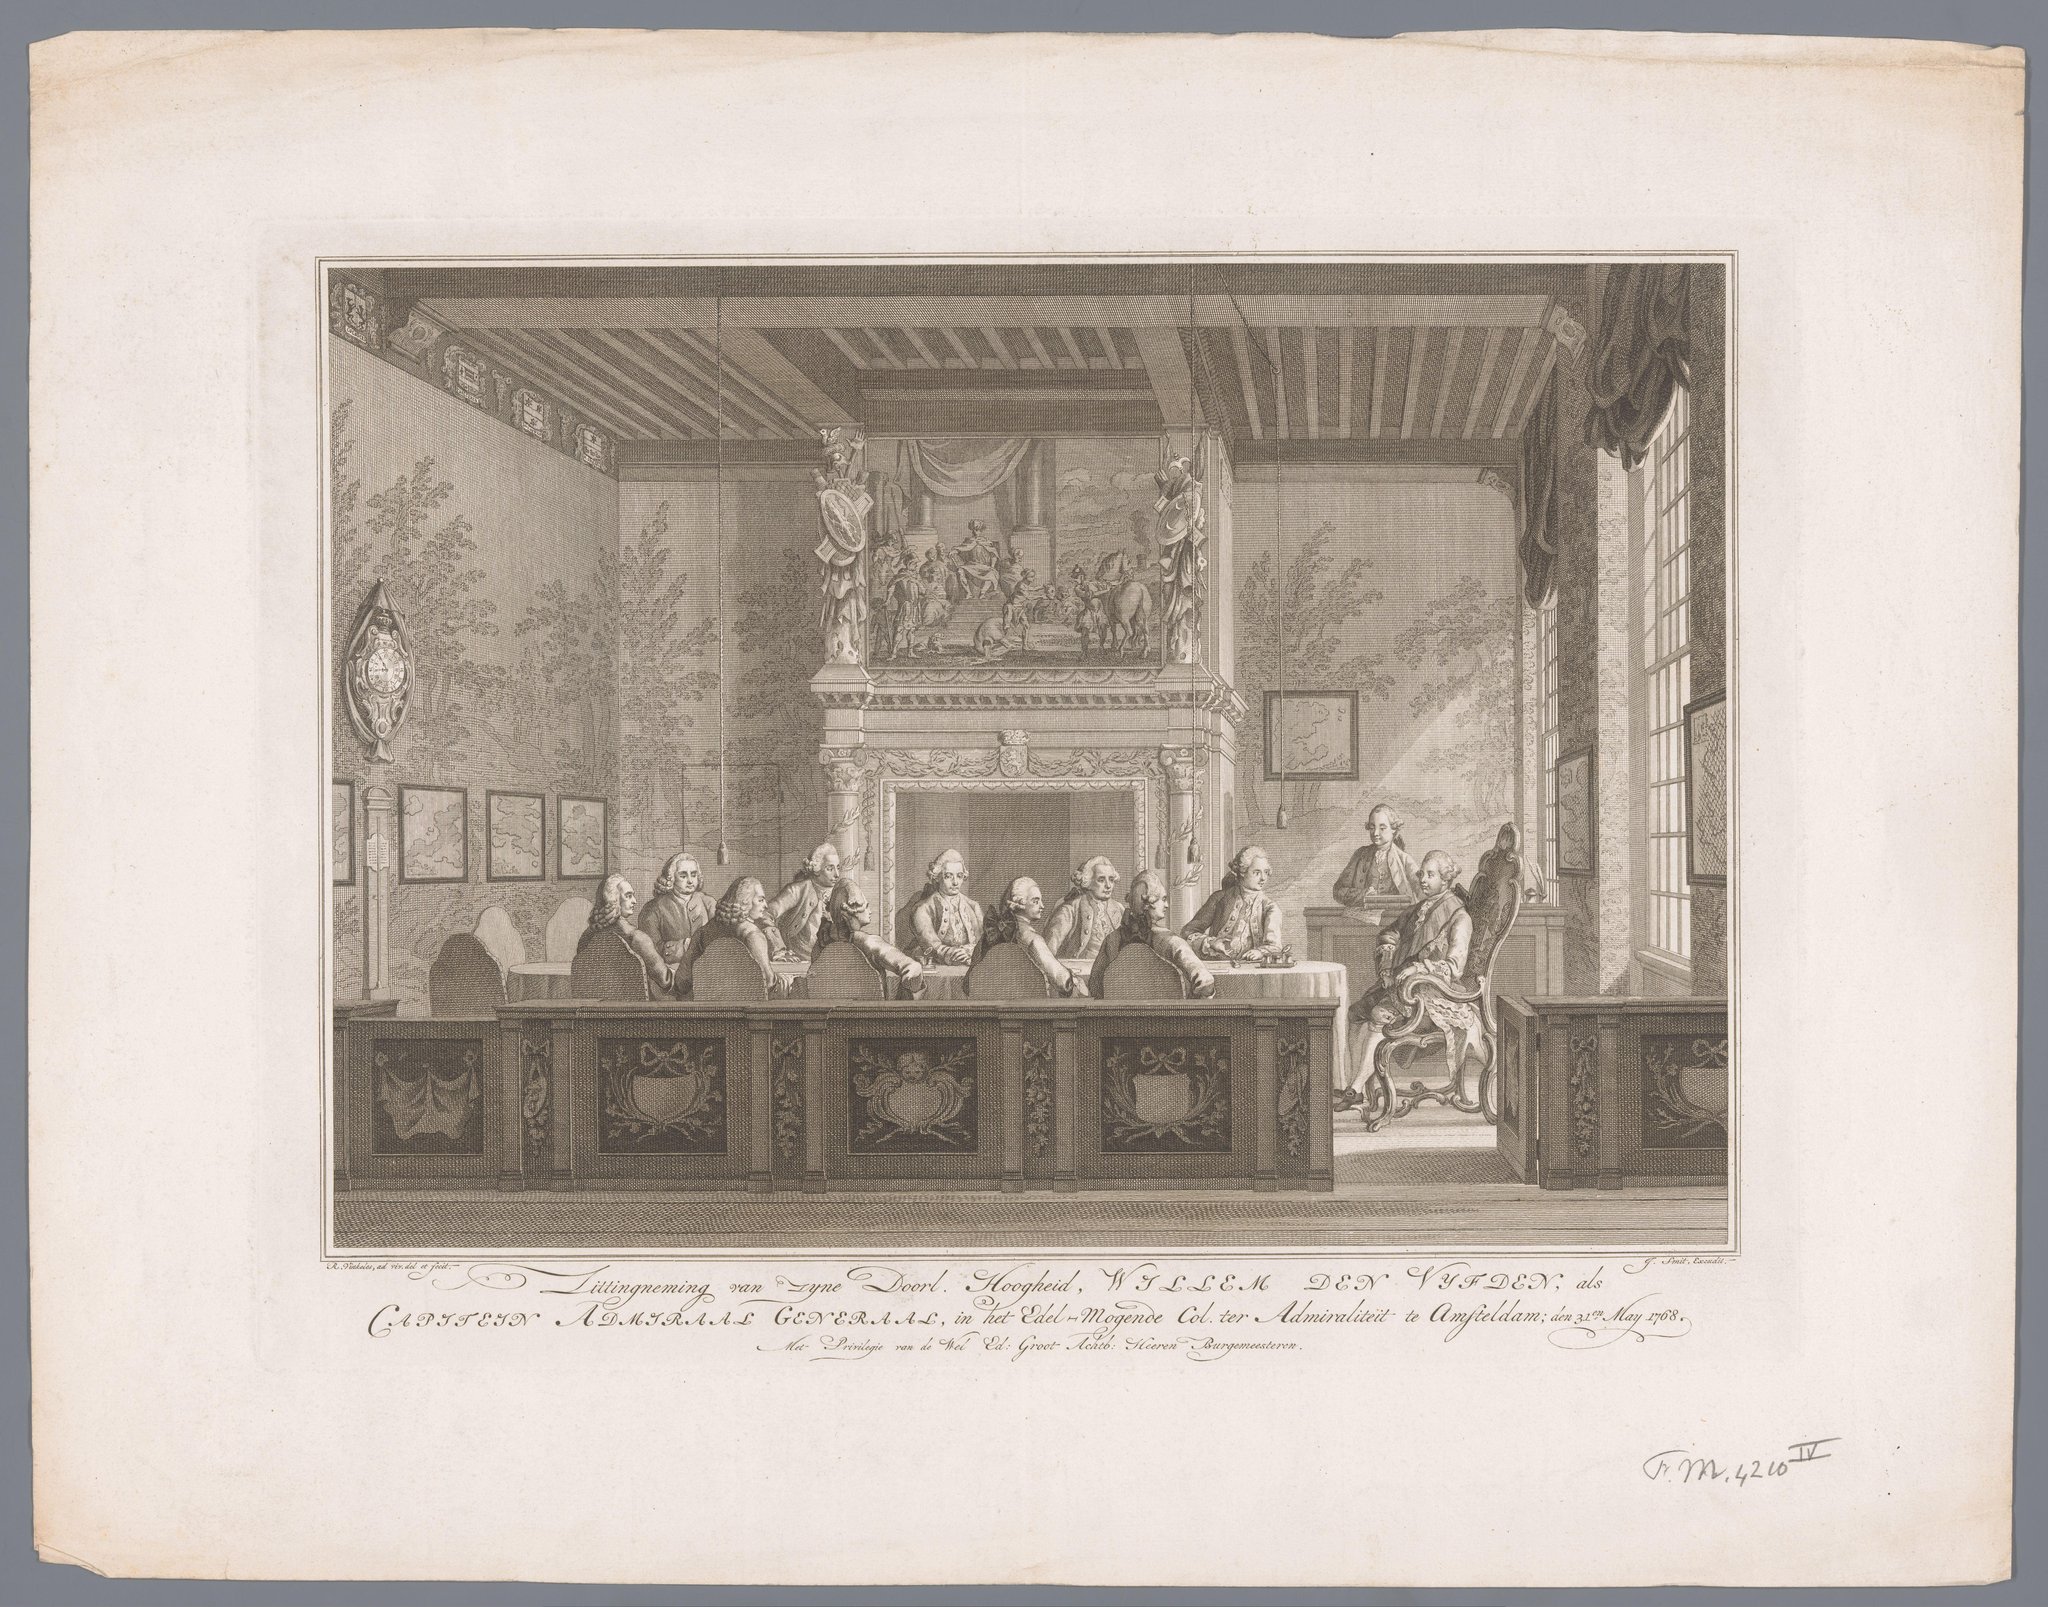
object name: print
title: Afbeelding der Vreugdebedryven en Plegtigheden die by de aankomst en gedurende het verblyf (...) Willem (...) en zyne Gemaalinne (...) zyn voorgevallen te Amsterdam, op maandag, den 30 Mey, en eenige volgende dagen, des jaars 1768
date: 1772-1773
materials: paper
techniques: etching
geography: amsterdam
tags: the hague, william v (prince of orange), berlin, painter, draughtsman, wilhelmina of prussia (princess of orange), interior ~ representation of a building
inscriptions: collector's mark: Lugt 2233